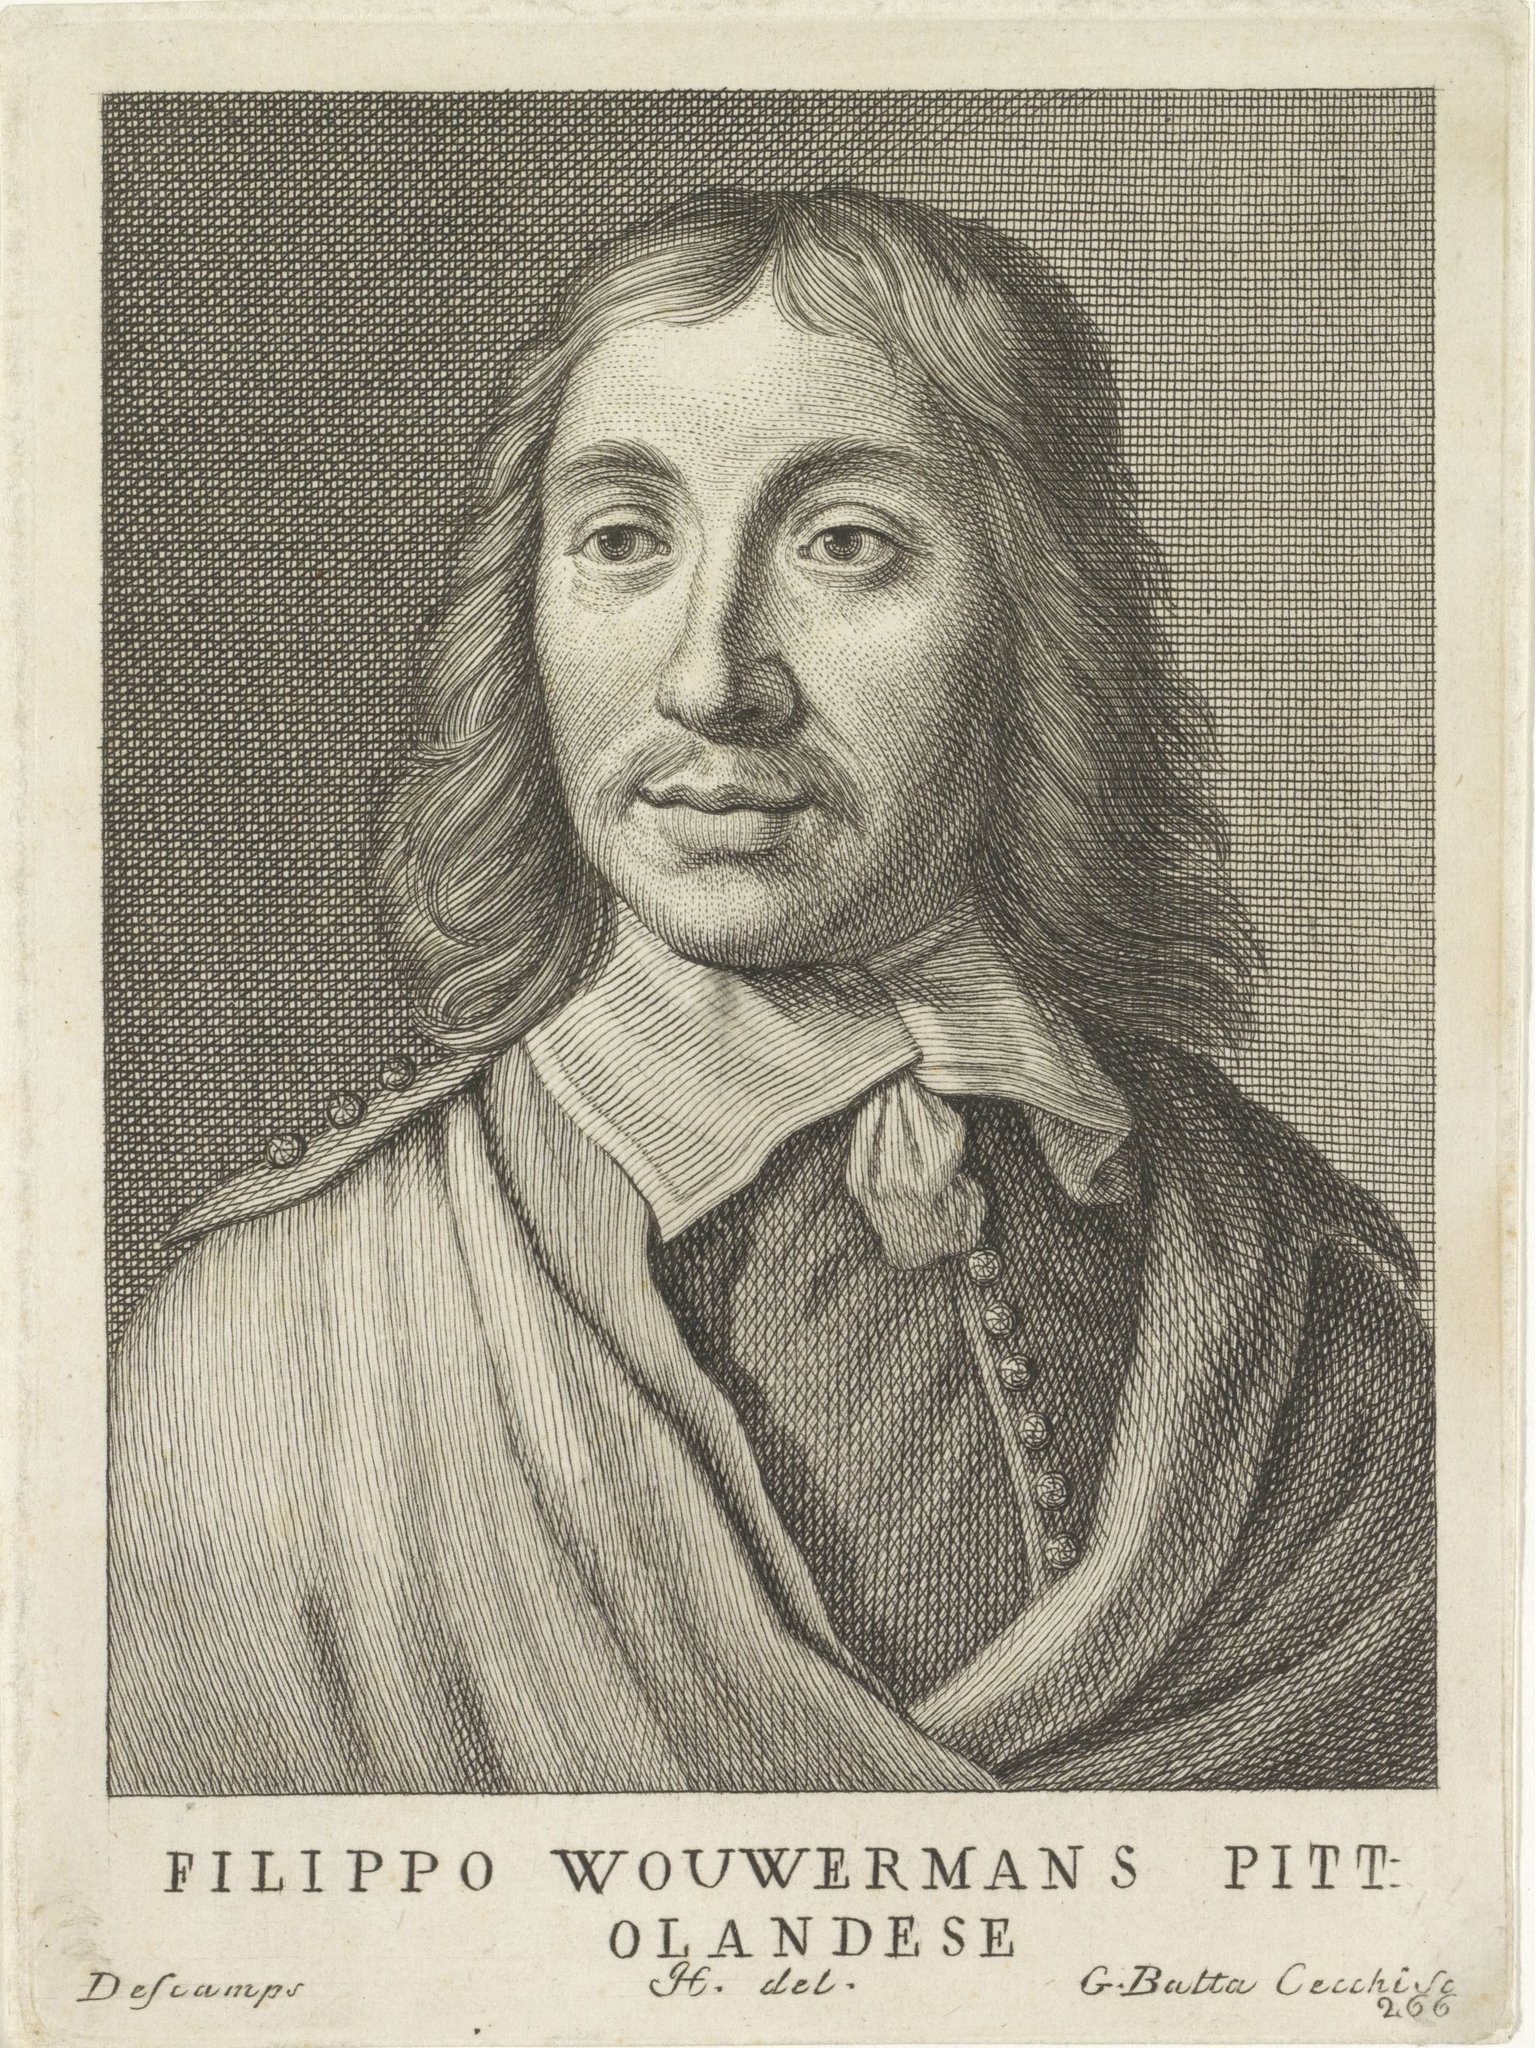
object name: book illustration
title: Portretten van kunstenaars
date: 1769-1775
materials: paper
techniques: engraving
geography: italy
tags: haarlem, painter, draughtsman, philips wouwerman, historical persons, portrait, self-portrait of artist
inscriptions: collector's mark: Lugt 2228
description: Prent gebruikt voor Pacini, Sante, Serie degli Uomini i più illustri nella pittura, scultura e architettura (12 vols.), Florence 1769-1775. Ieder deel is onderverdeeld in verschillende hoofdstukken, elk bestaande uit de lofrede op een kunstenaar voorafgegaan door een gegraveerde portret van de deze kunstenaar.